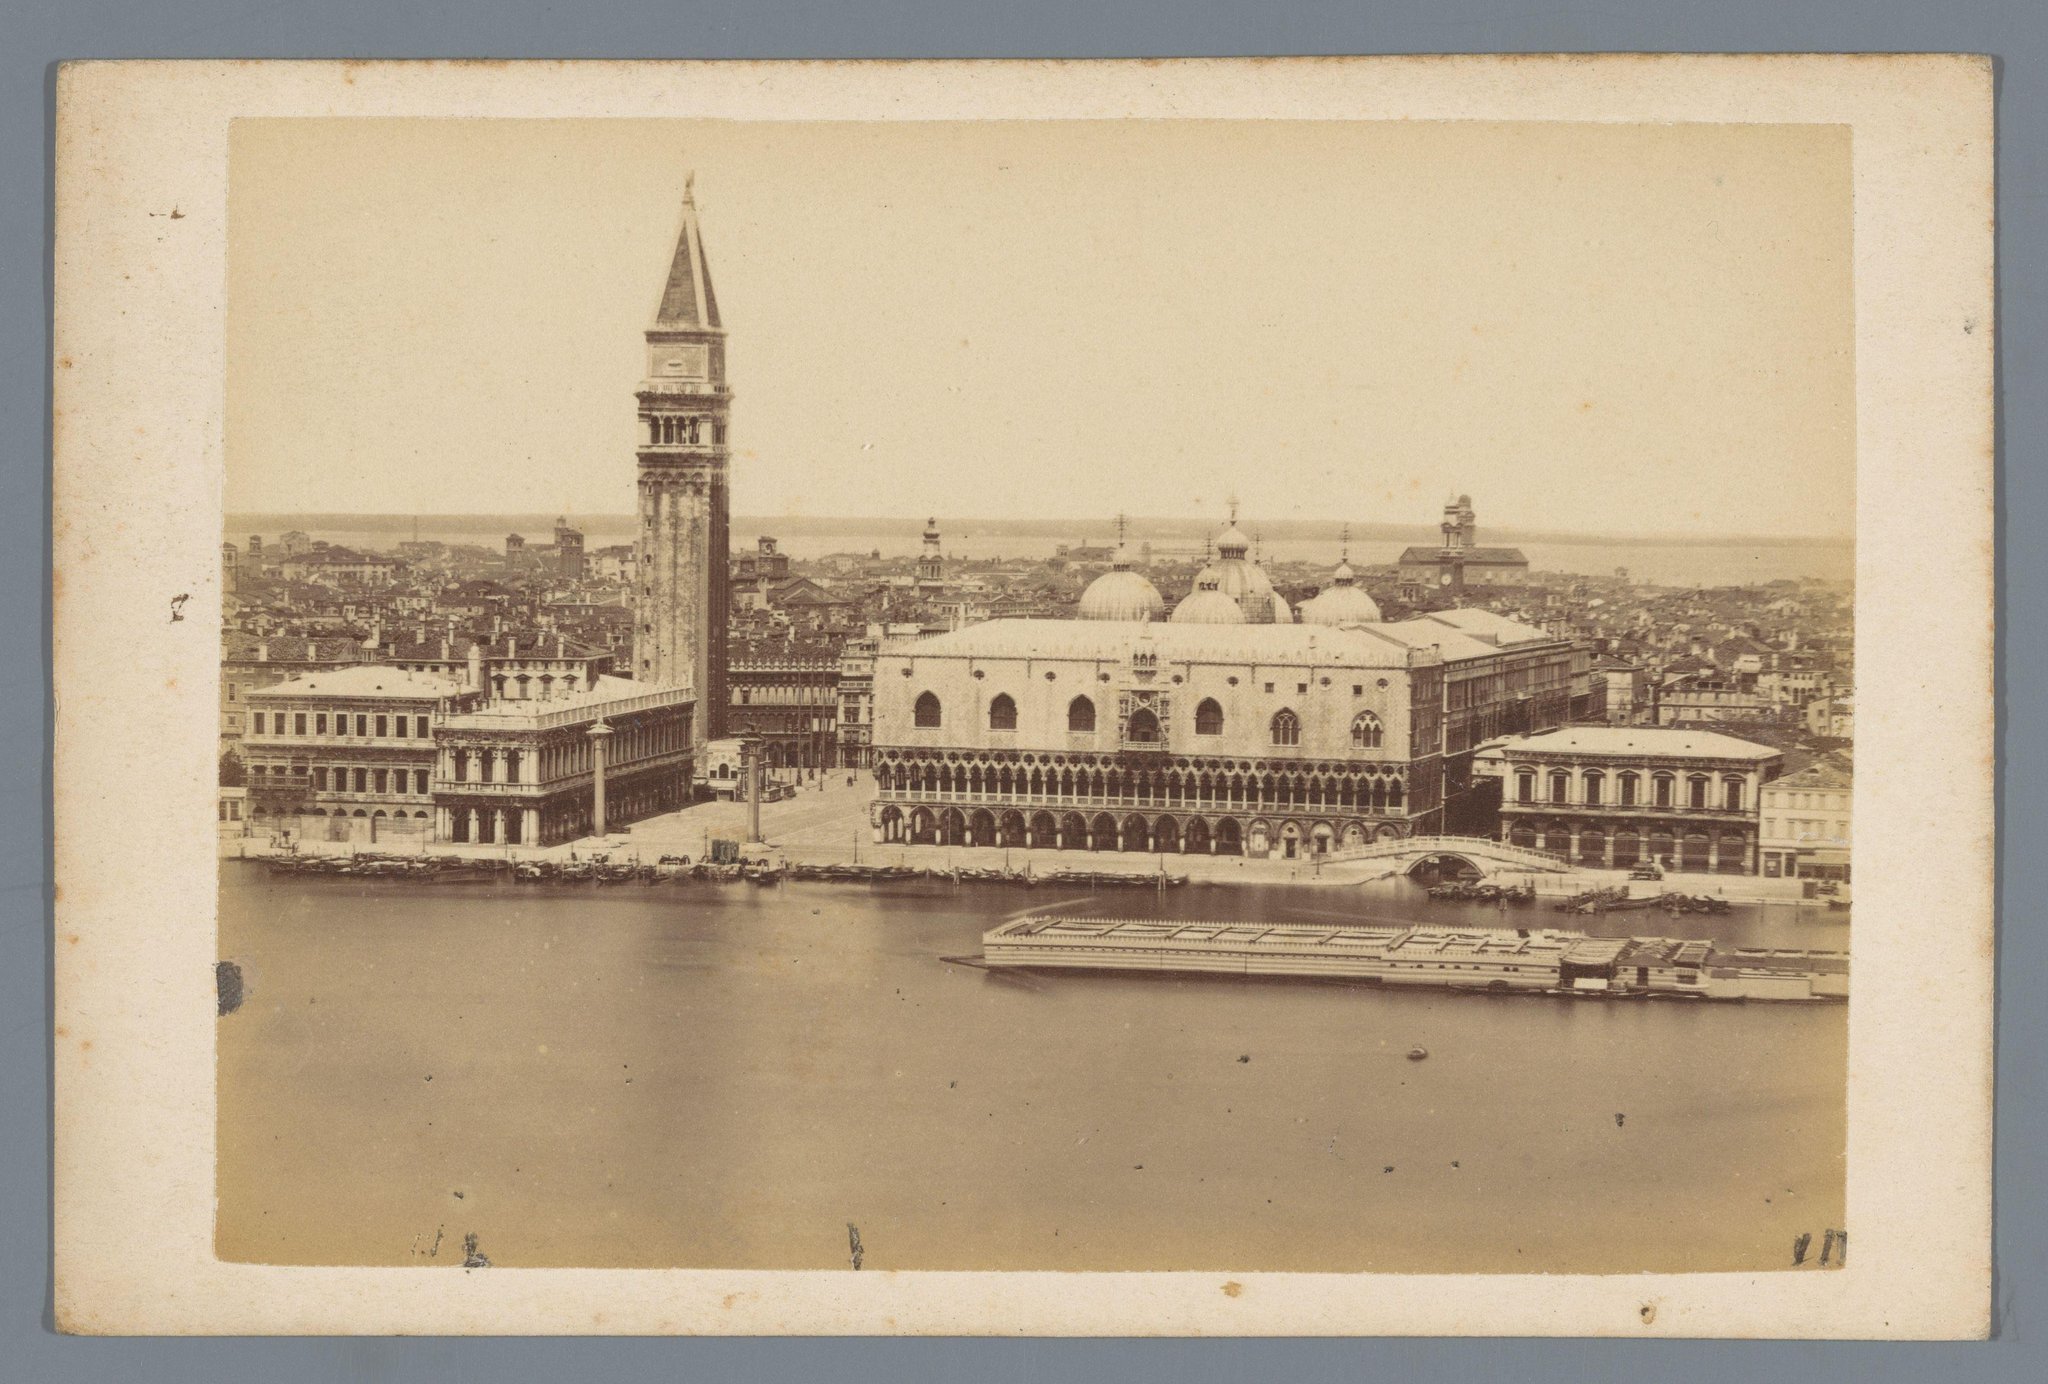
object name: cabinet photograph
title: Gezicht op Venetië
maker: Anonymous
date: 1850-1900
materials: cardboard, photographic support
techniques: albumen print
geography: venice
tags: city-view, and landscape with man-made constructions, canals, waters (in city), venice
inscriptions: annotation: ‘Venize panorama’